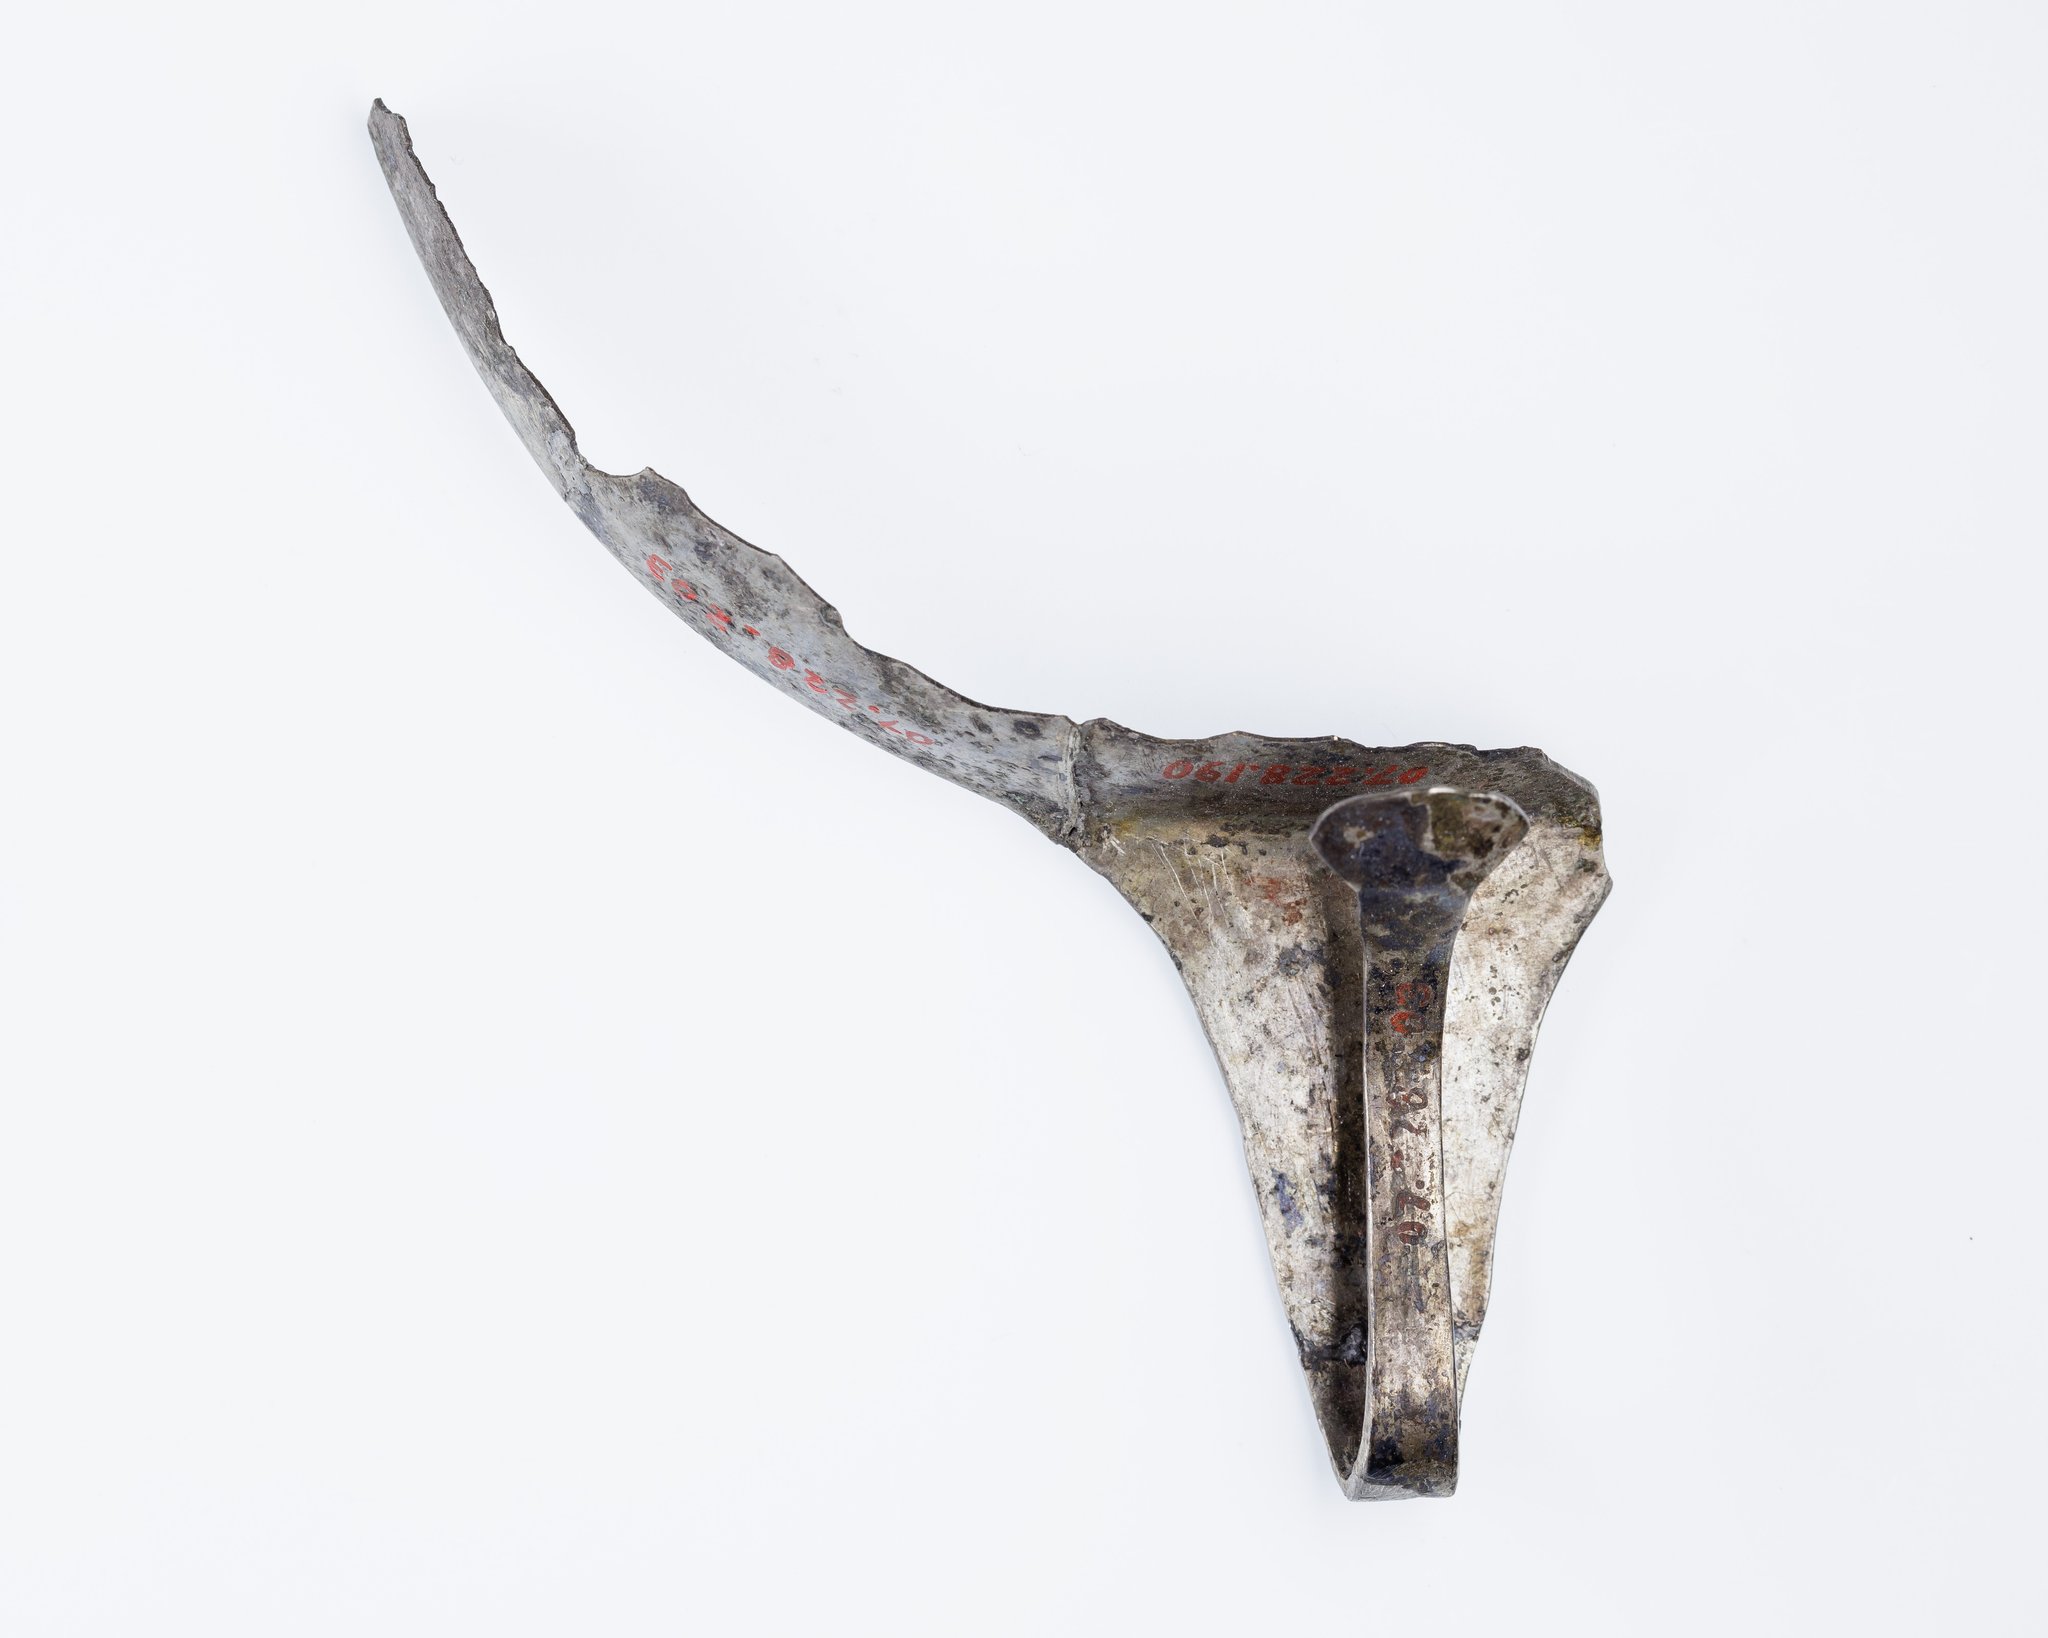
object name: strainer fragment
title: Rim fragment with lotus handle from a shallow strainer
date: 1279-1213 BCE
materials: silver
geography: egypt